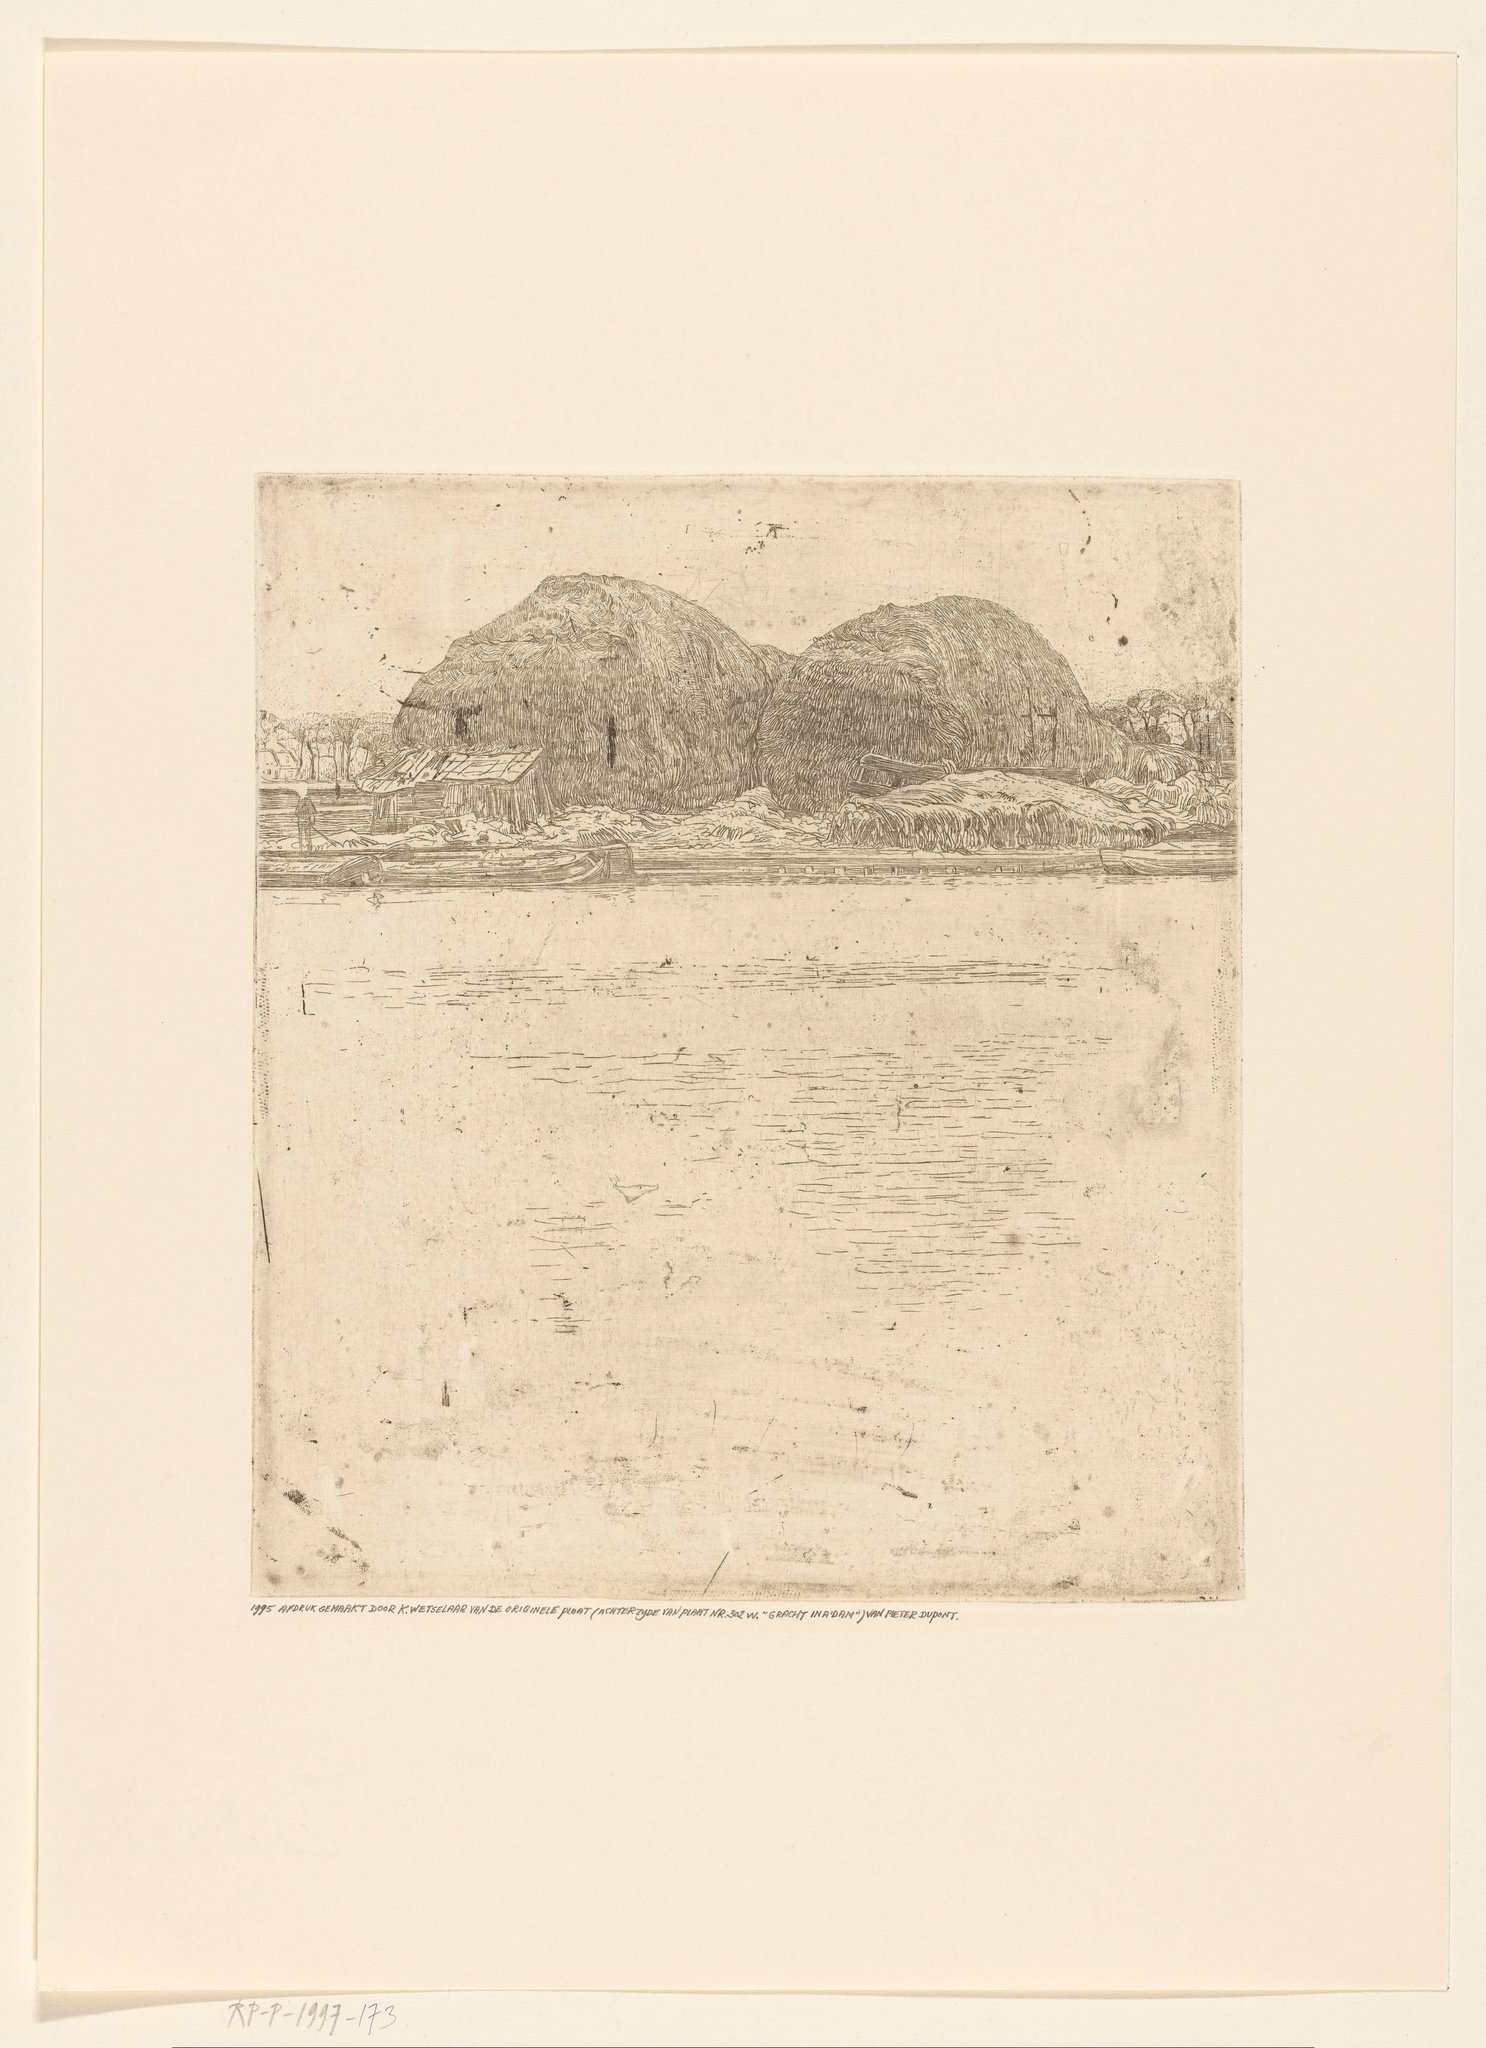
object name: print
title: Twee hooibergen op een oever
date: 1880-1911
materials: paper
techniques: etching, intaglio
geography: netherlands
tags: water course, hay-stack, netherlands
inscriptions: collector's mark: Lugt 2228, inscription: ‘1995 Afdruk gemaakt door K. Wetselaar van de originele plaat (achterzijde van plaat nr. 302 w. "Gracht in A'dam") van Pieter Dupont.’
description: Aan de oever liggen enkele afgemeerde schuiten.